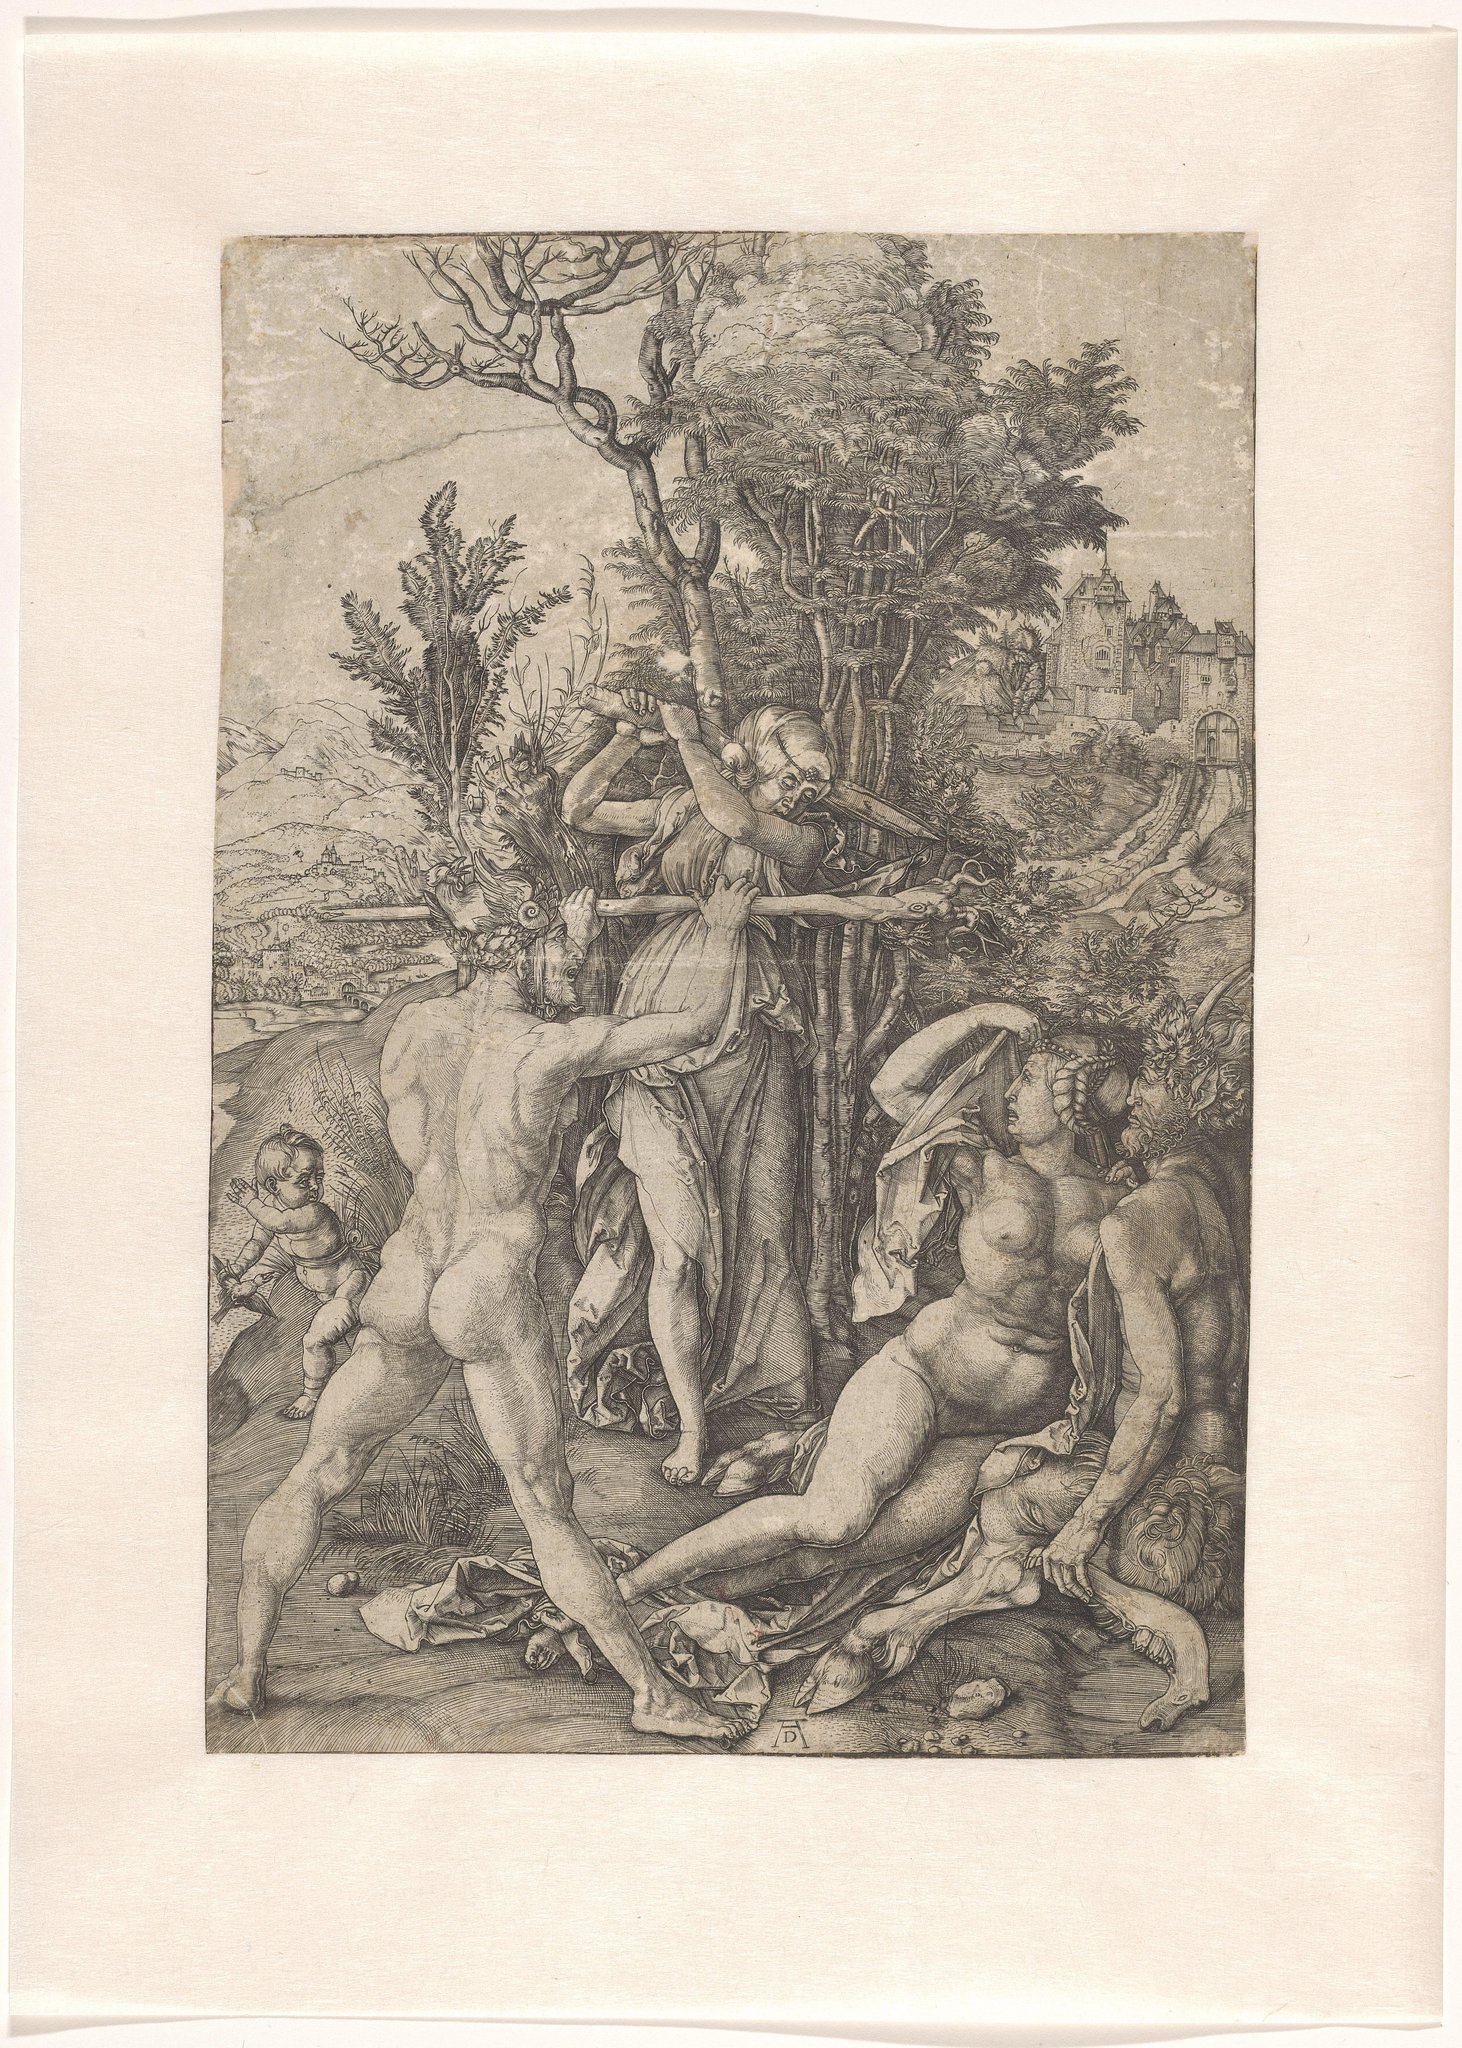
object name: print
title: Hercules op de tweesprong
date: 1498-1534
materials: paper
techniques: engraving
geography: italy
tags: city-view, and landscape with man-made constructions, (showing oneself) undressed, quasi-nude, hercules at the cross-roads, 'herkules am scheidewege': the choice of hercules, satyr(s) (in general), fighting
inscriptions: collector's mark: Lugt 240